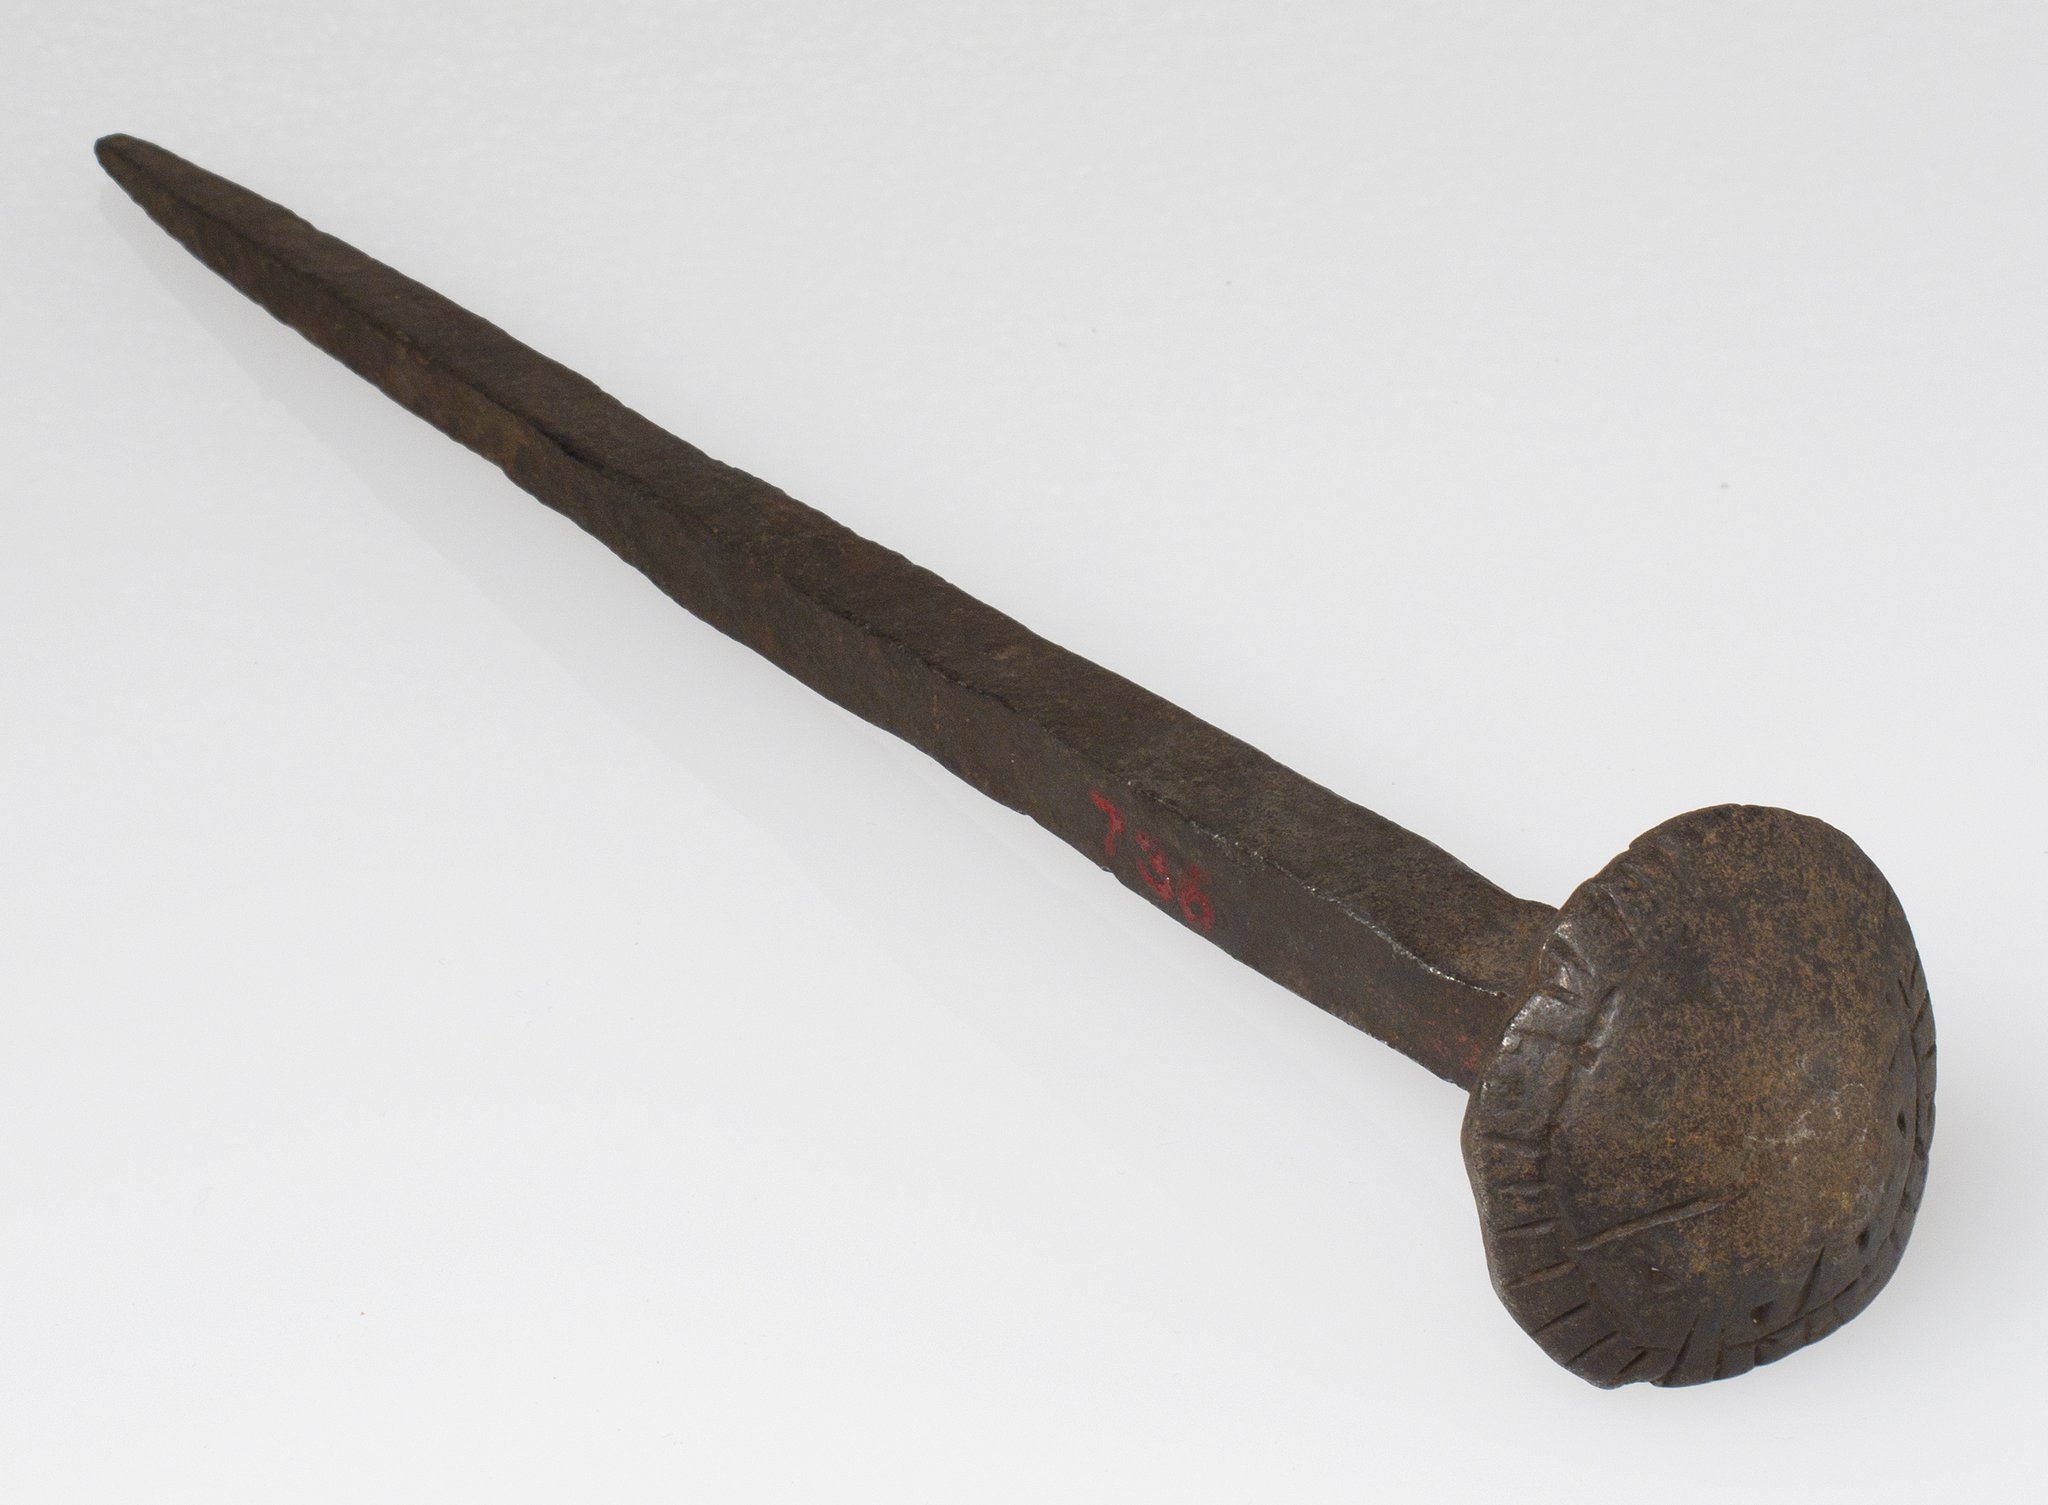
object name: nail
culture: european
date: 1401-1600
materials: iron